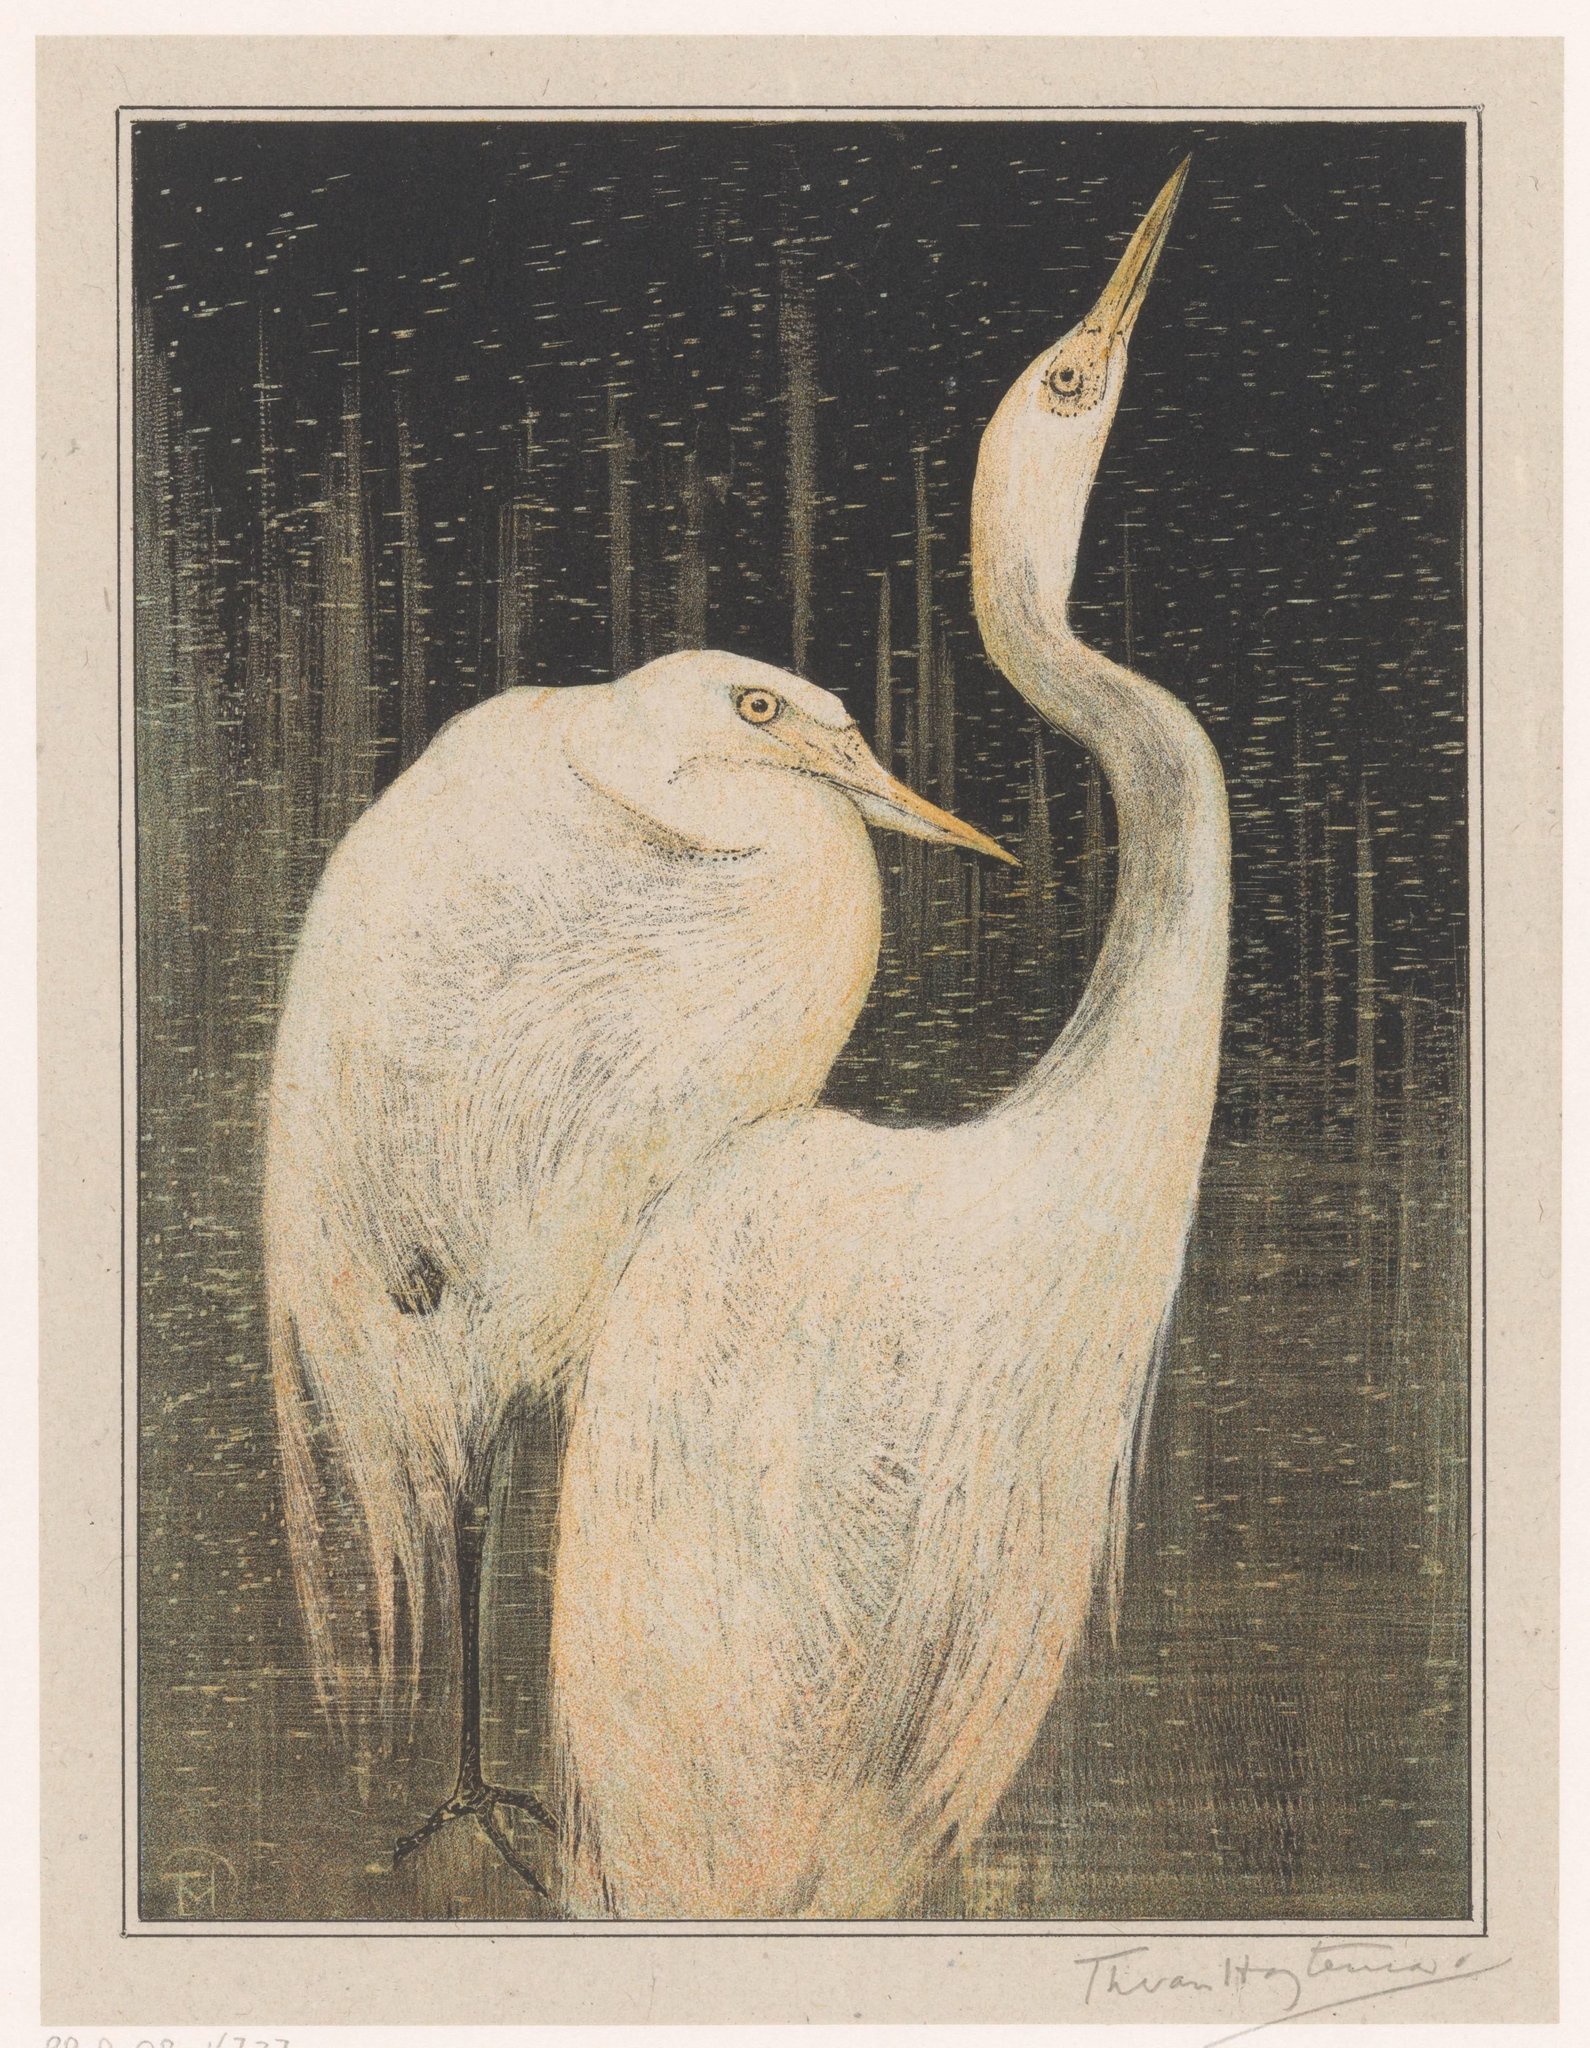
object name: print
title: Twee zilverreigers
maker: theo van hoytema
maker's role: draughtsman, painter, print maker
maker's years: 1863-1917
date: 1878-1905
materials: paper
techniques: lithograph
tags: shore-birds and wading-birds: heron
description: Een reiger met uitgestoken nek; de ander ineengedoken.